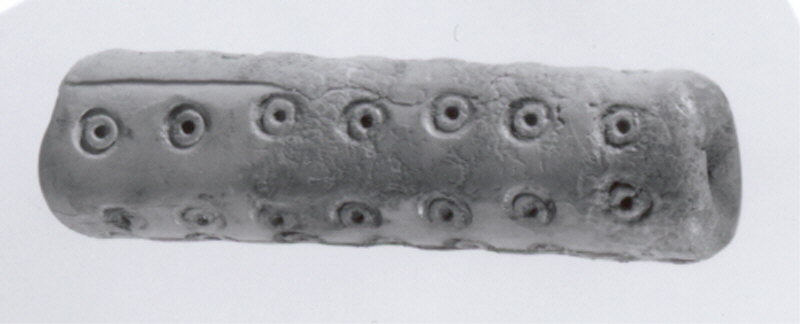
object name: cosmetic container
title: Cosmetic container (?)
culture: iranian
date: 900-801 BCE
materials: bone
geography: iran